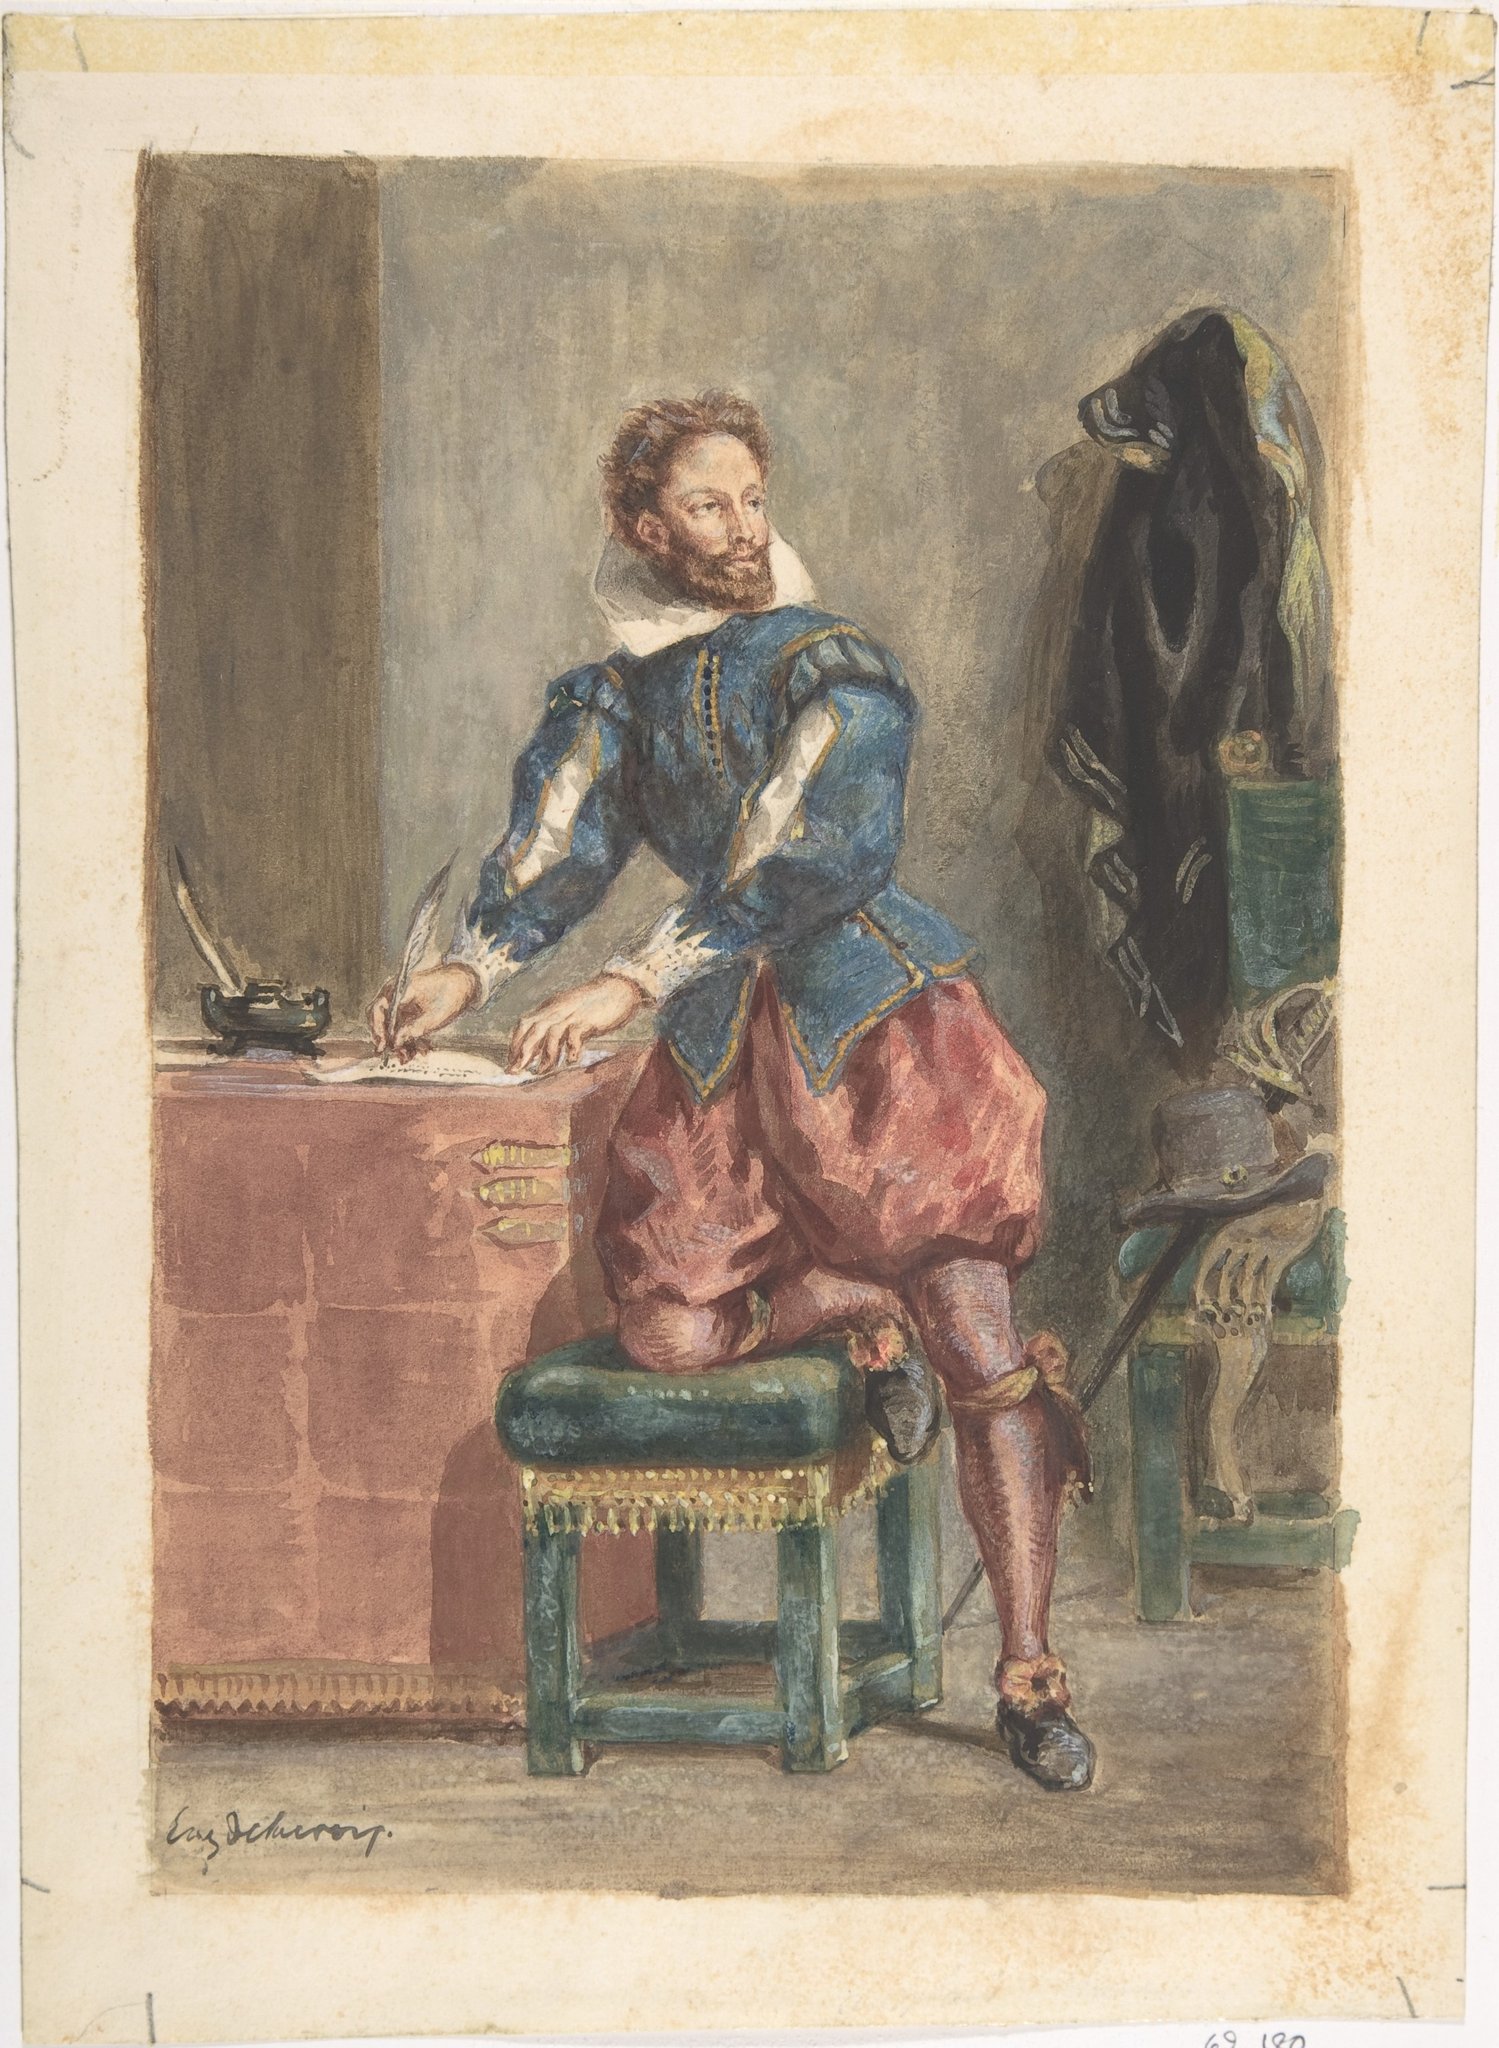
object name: drawing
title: Mathurin Régnier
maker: eugène delacroix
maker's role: artist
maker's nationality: french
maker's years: 1798-1863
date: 1846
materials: gouache, graphite, watercolor, paper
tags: men,writing